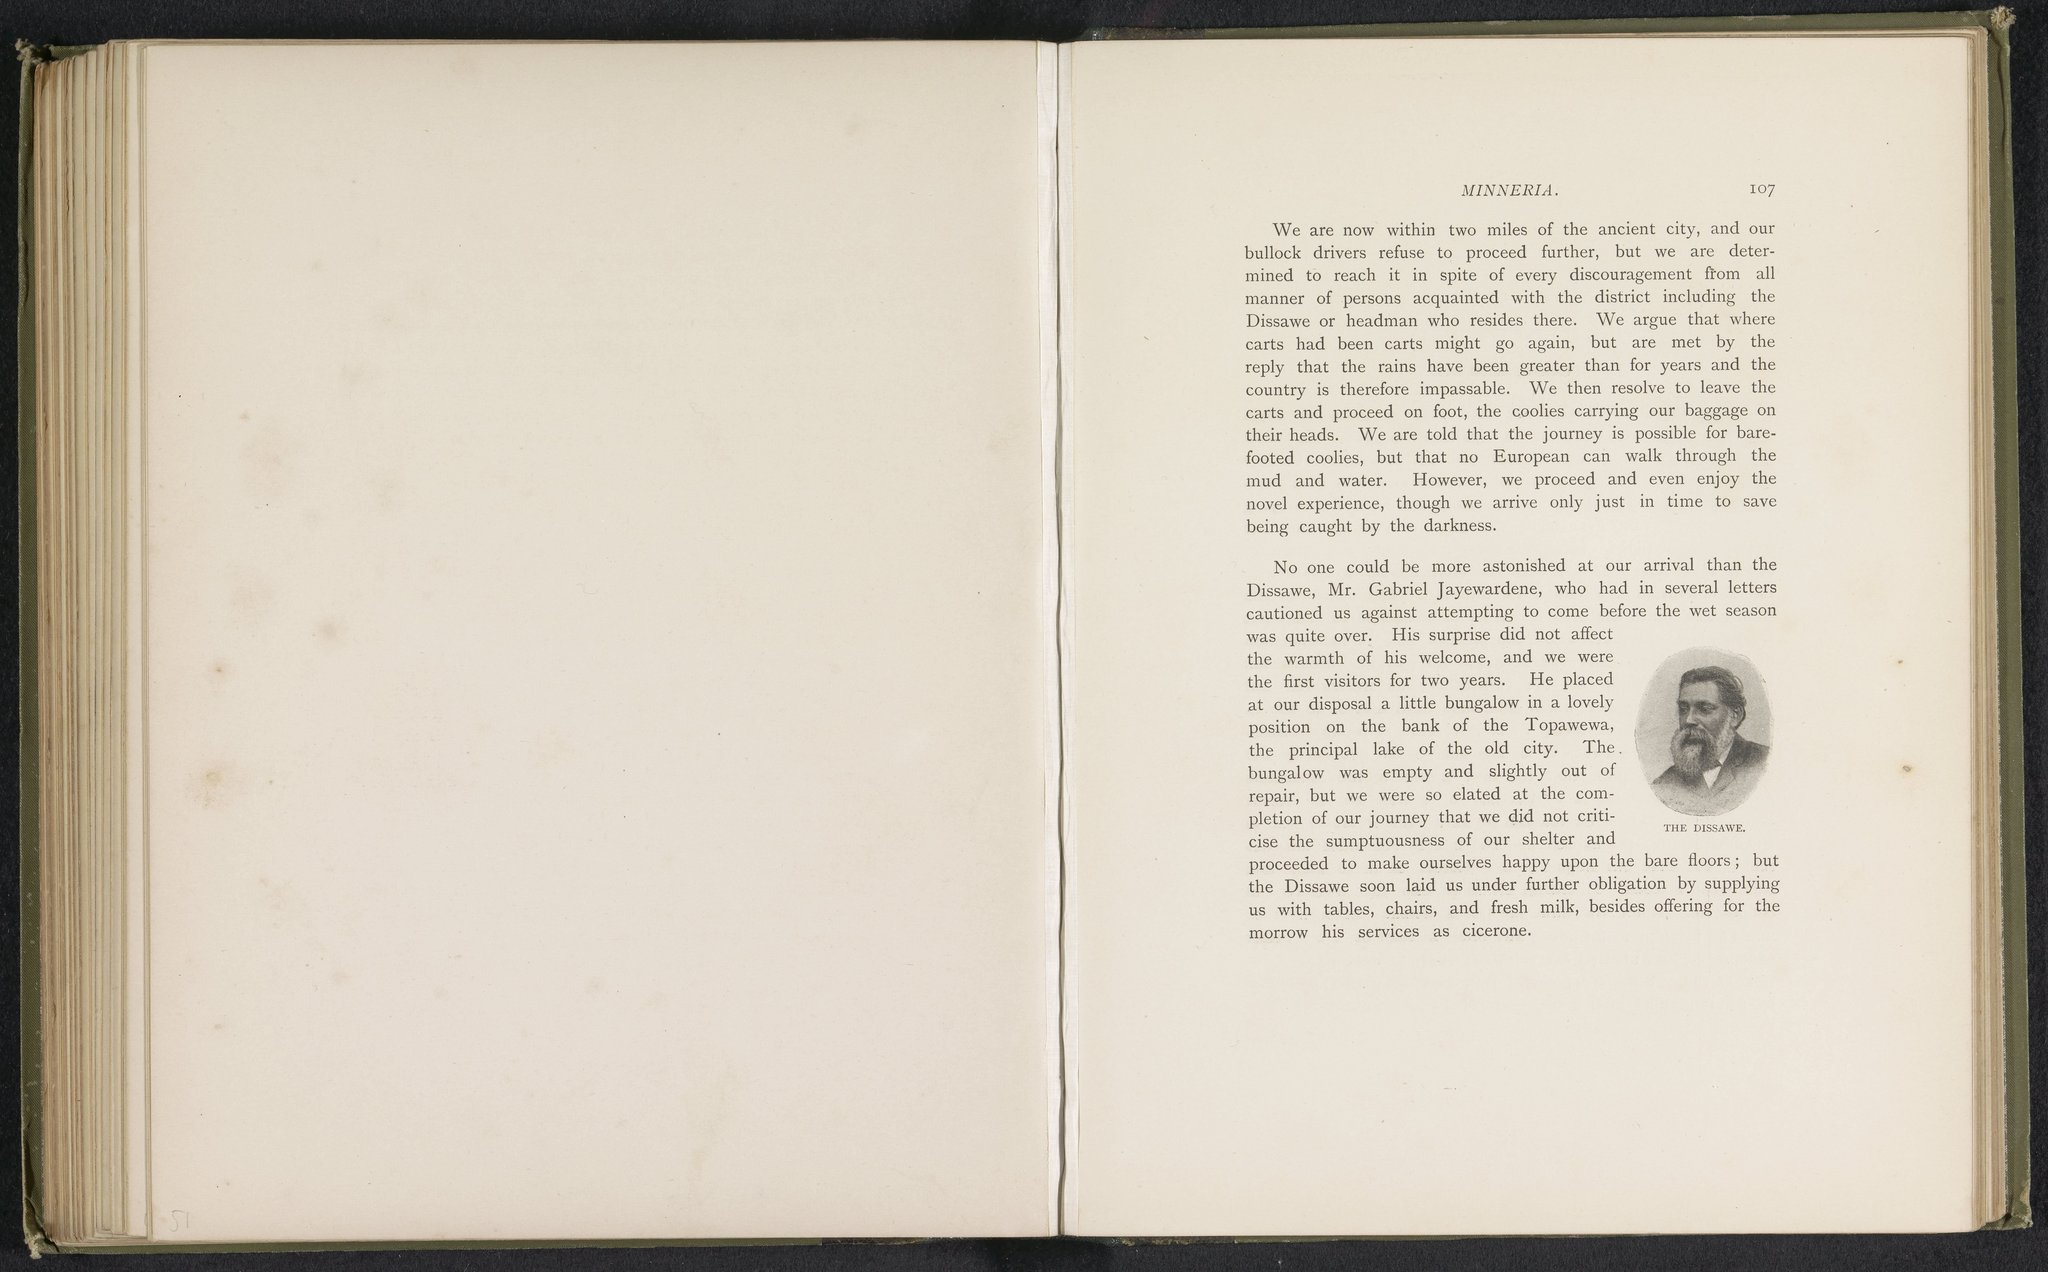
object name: page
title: Portrait of the dissawe Gabriel Jayewardene, Sri Lanka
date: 1896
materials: paper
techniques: autotype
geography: polonnaruwa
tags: official; civil servant; functionary (in general)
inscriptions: title: ‘THE DISSAWE.’